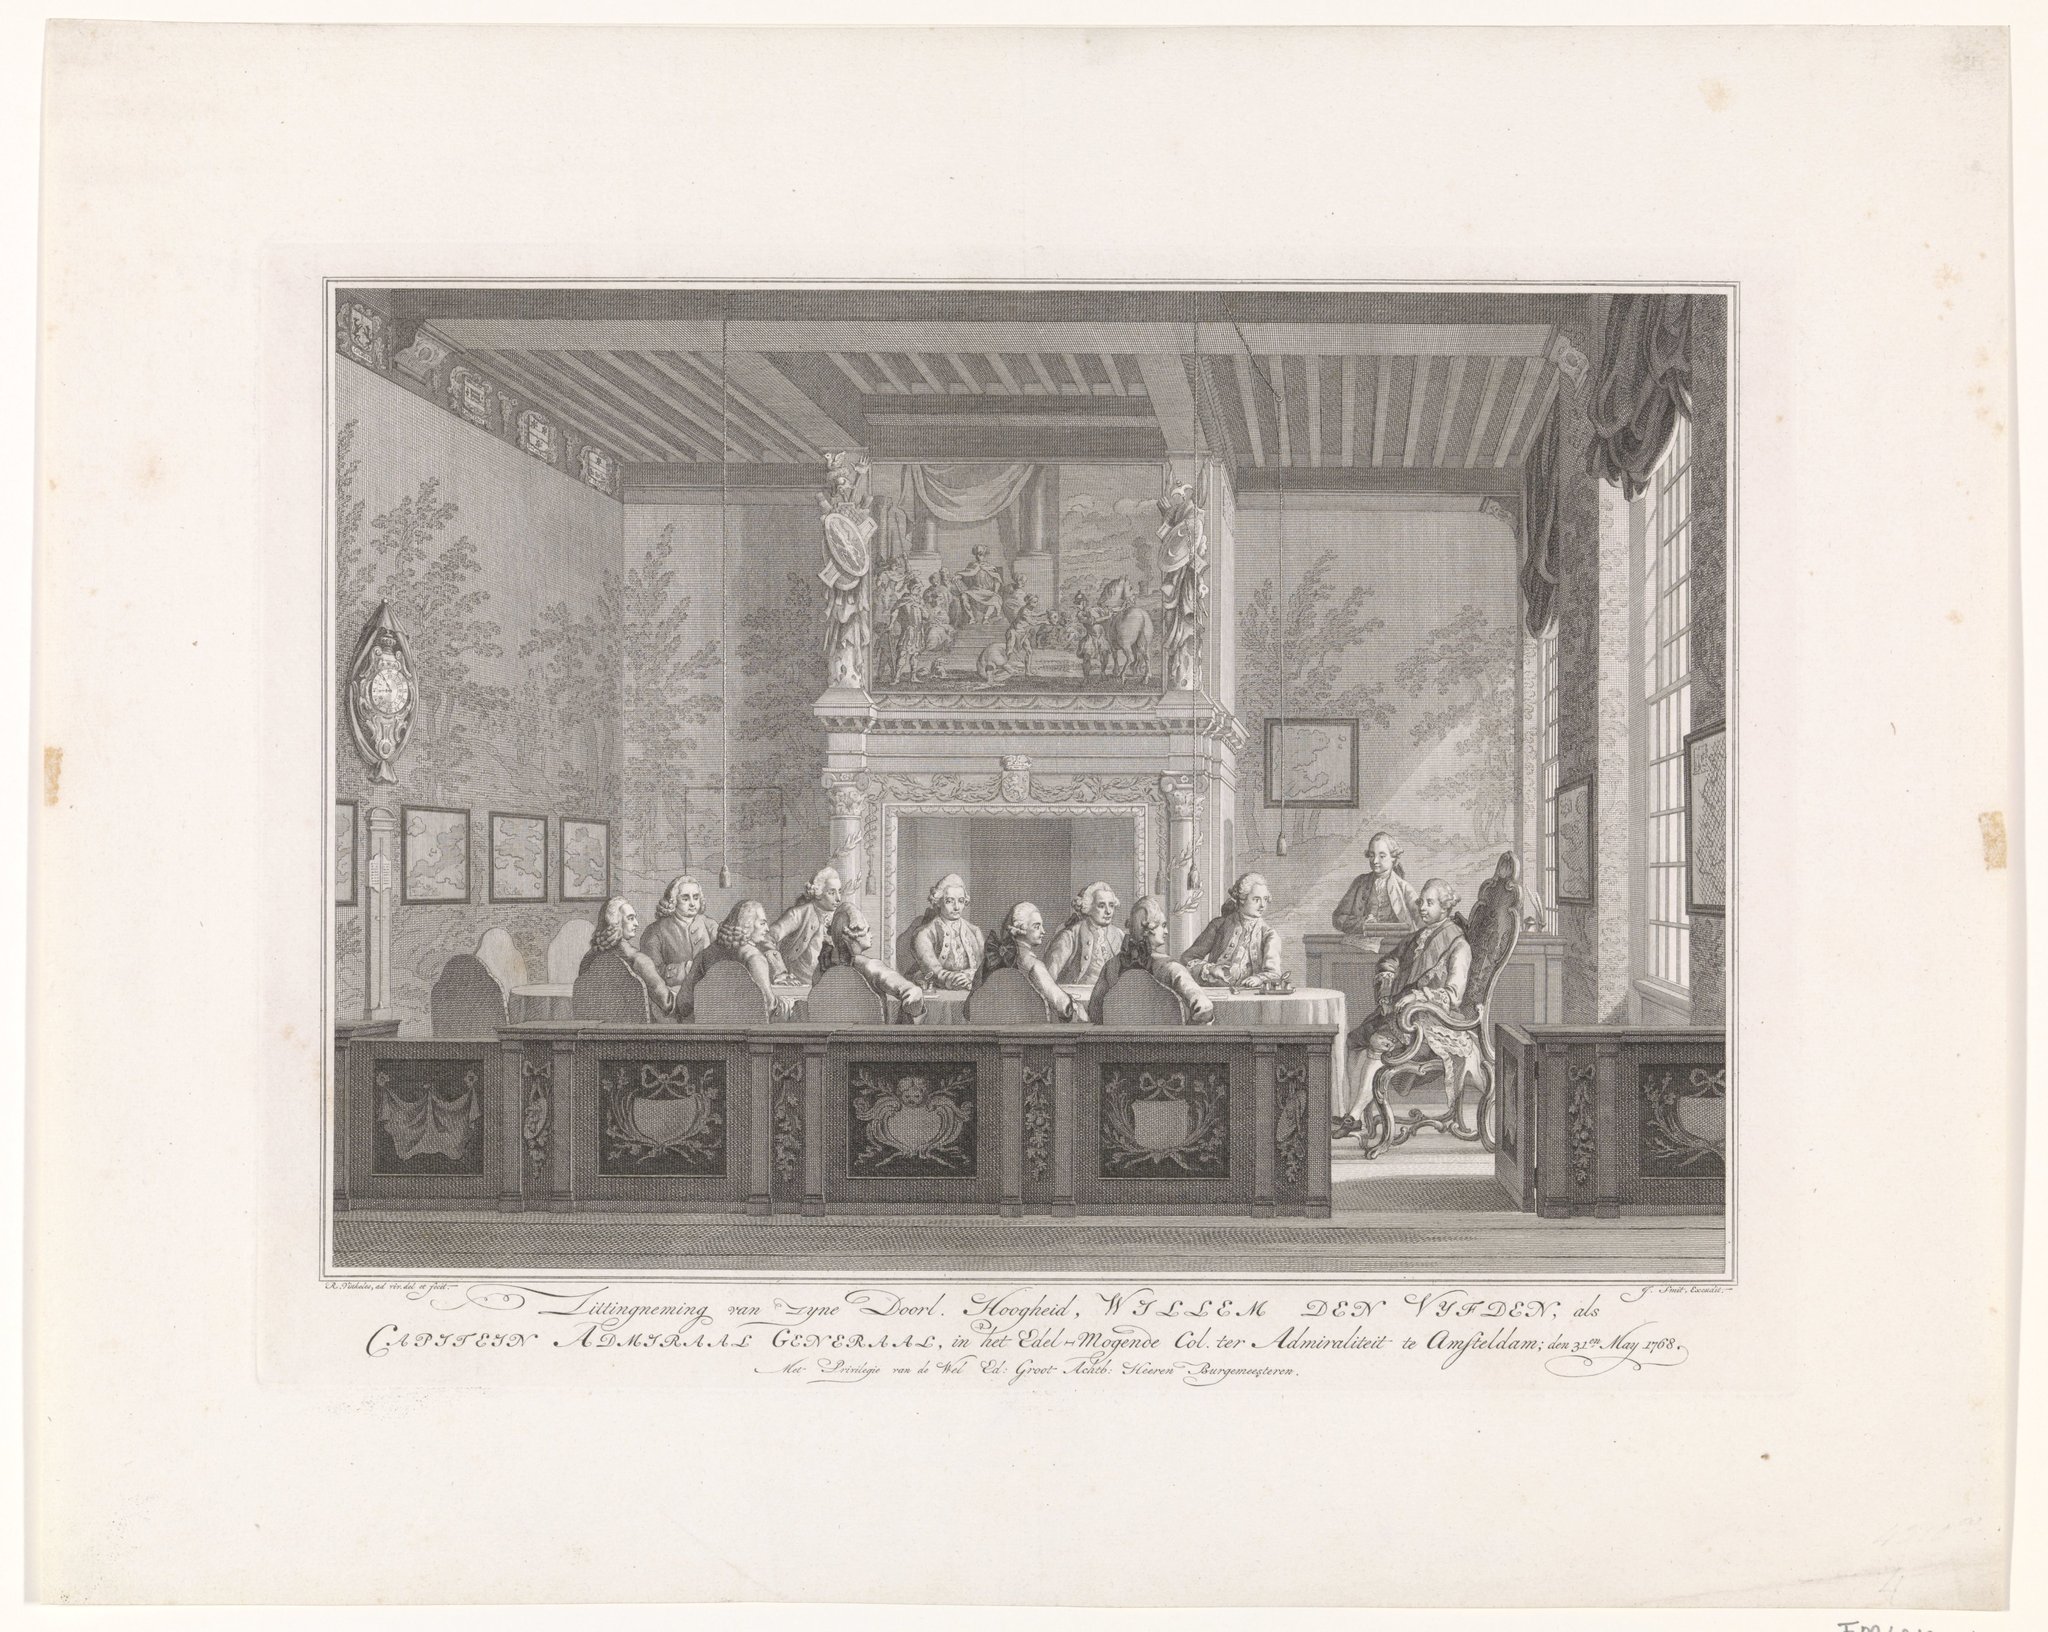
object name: print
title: Afbeelding der Vreugdebedryven en Plegtigheden die by de aankomst en gedurende het verblyf (...) Willem (...) en zyne Gemaalinne (...) zyn voorgevallen te Amsterdam, op maandag, den 30 Mey, en eenige volgende dagen, des jaars 1768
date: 1769-1773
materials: paper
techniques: engraving, etching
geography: northern netherlands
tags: the hague, william v (prince of orange), berlin, painter, draughtsman, wilhelmina of prussia (princess of orange)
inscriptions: collector's mark: Lugt 2228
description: Stadhouder Willem V neemt als kapitein admiraal generaal zitting in het college van de Admiraliteit te Amsterdam, op 31 mei 1768. Onderdeel van een prentserie met titelprent en 14 platen van de inhaling van de prins en prinses te Amsterdam, 30 mei - 4 juni 1768.